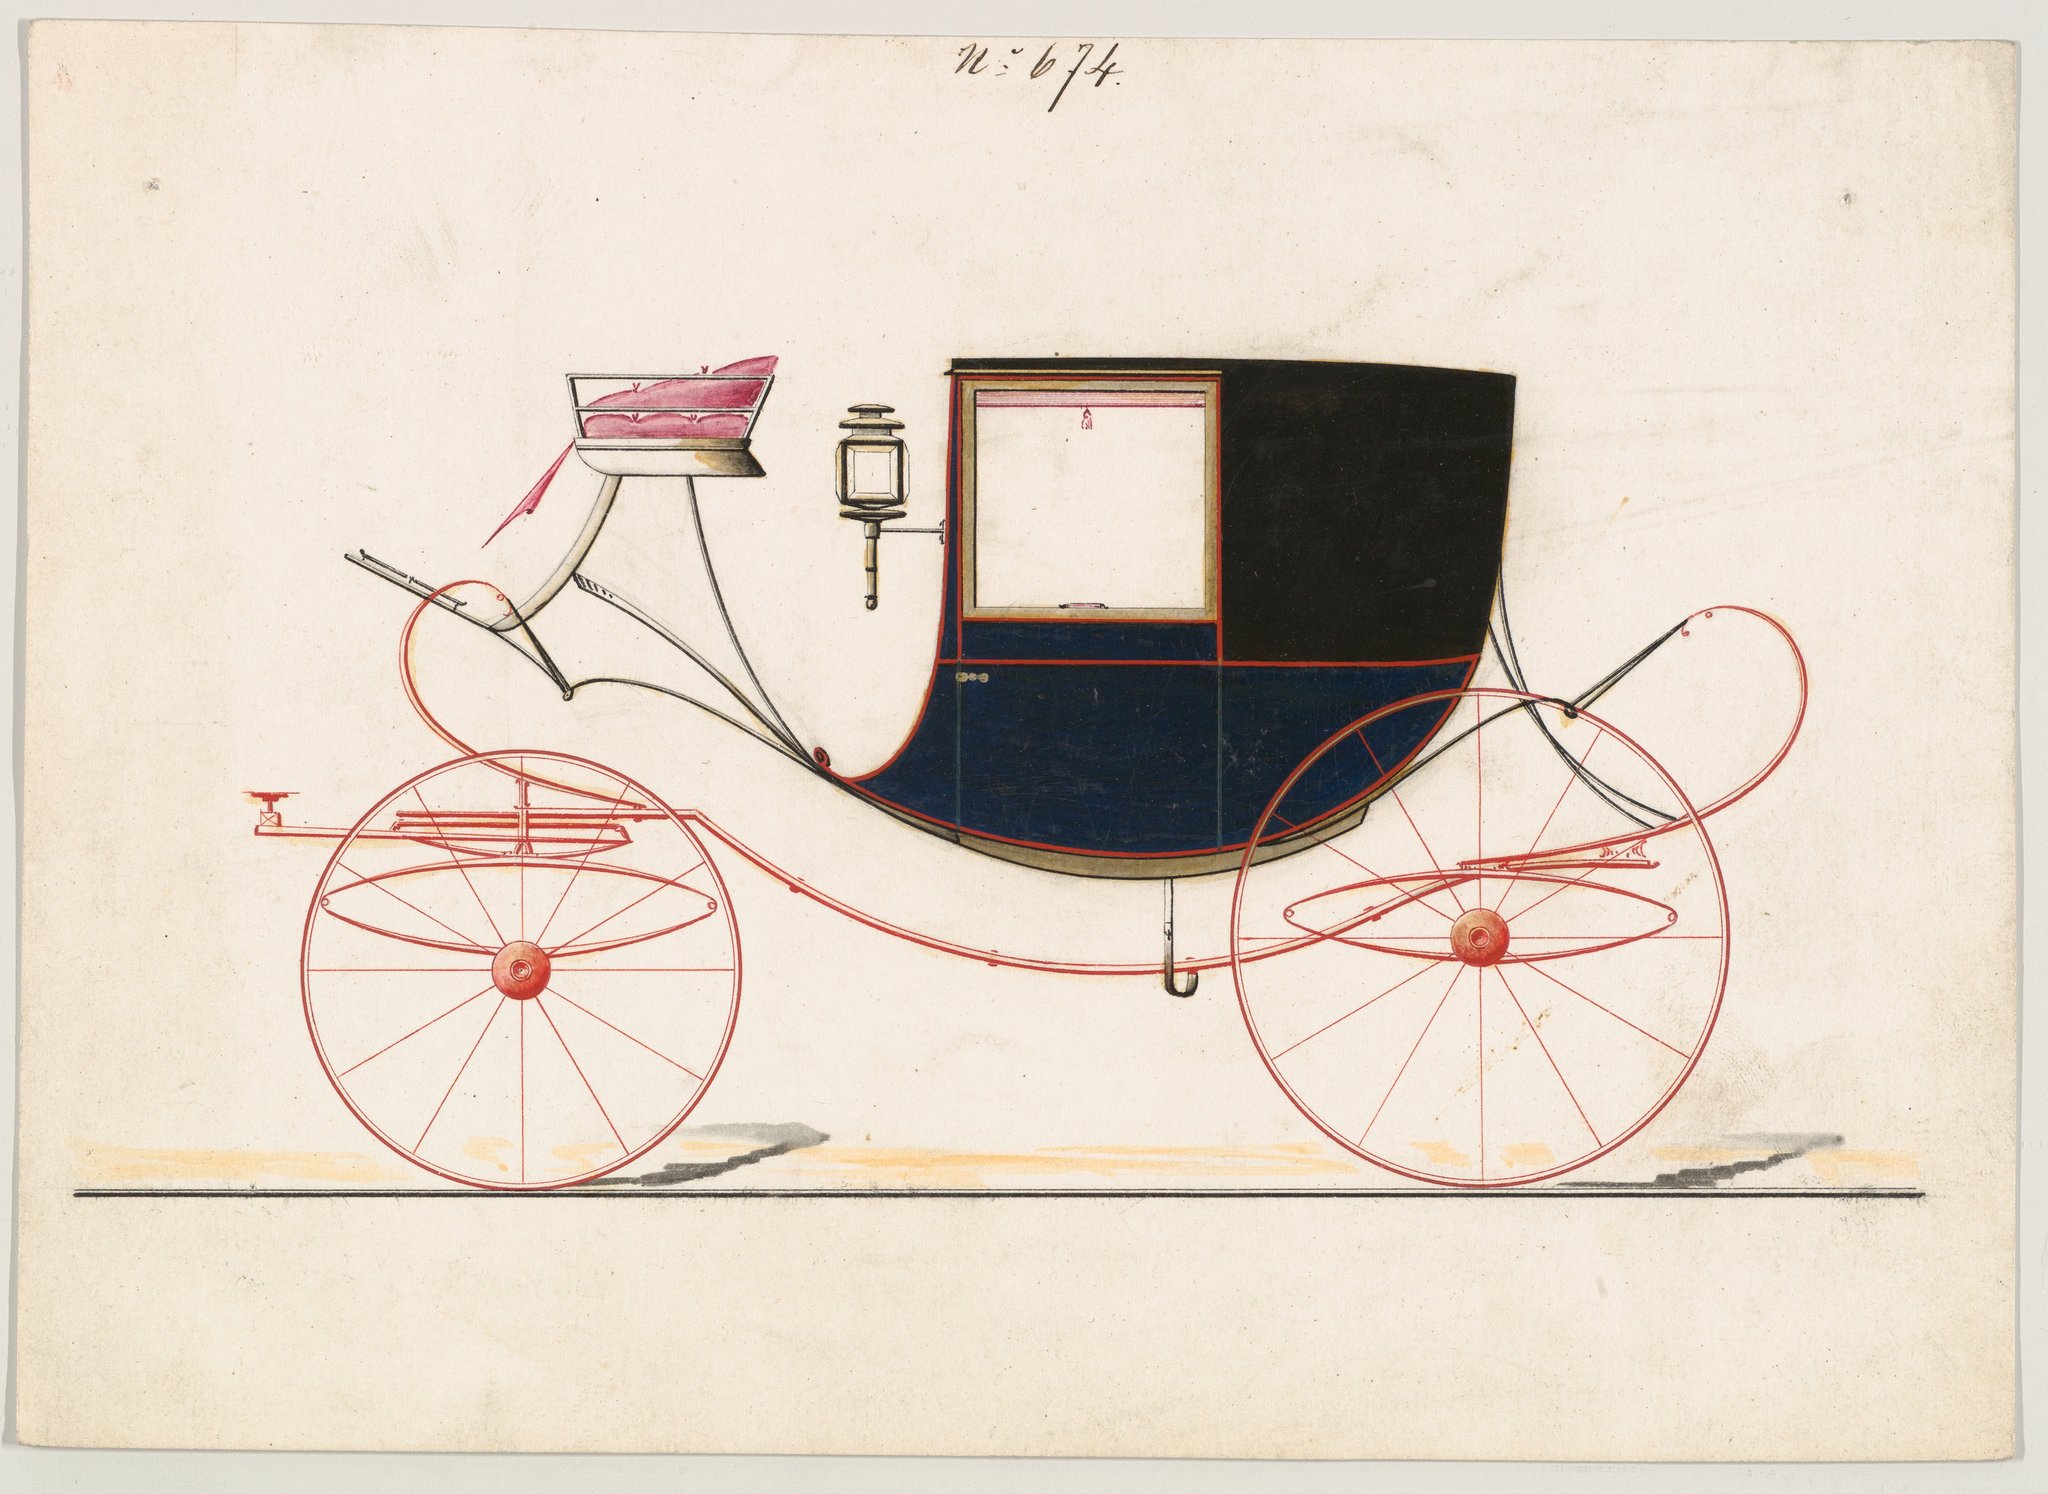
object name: drawing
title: Coupe #674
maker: brewster & co.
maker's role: manufacturer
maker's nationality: american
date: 1860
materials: gouache, gum arabic, ink, watercolor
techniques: pen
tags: carriages